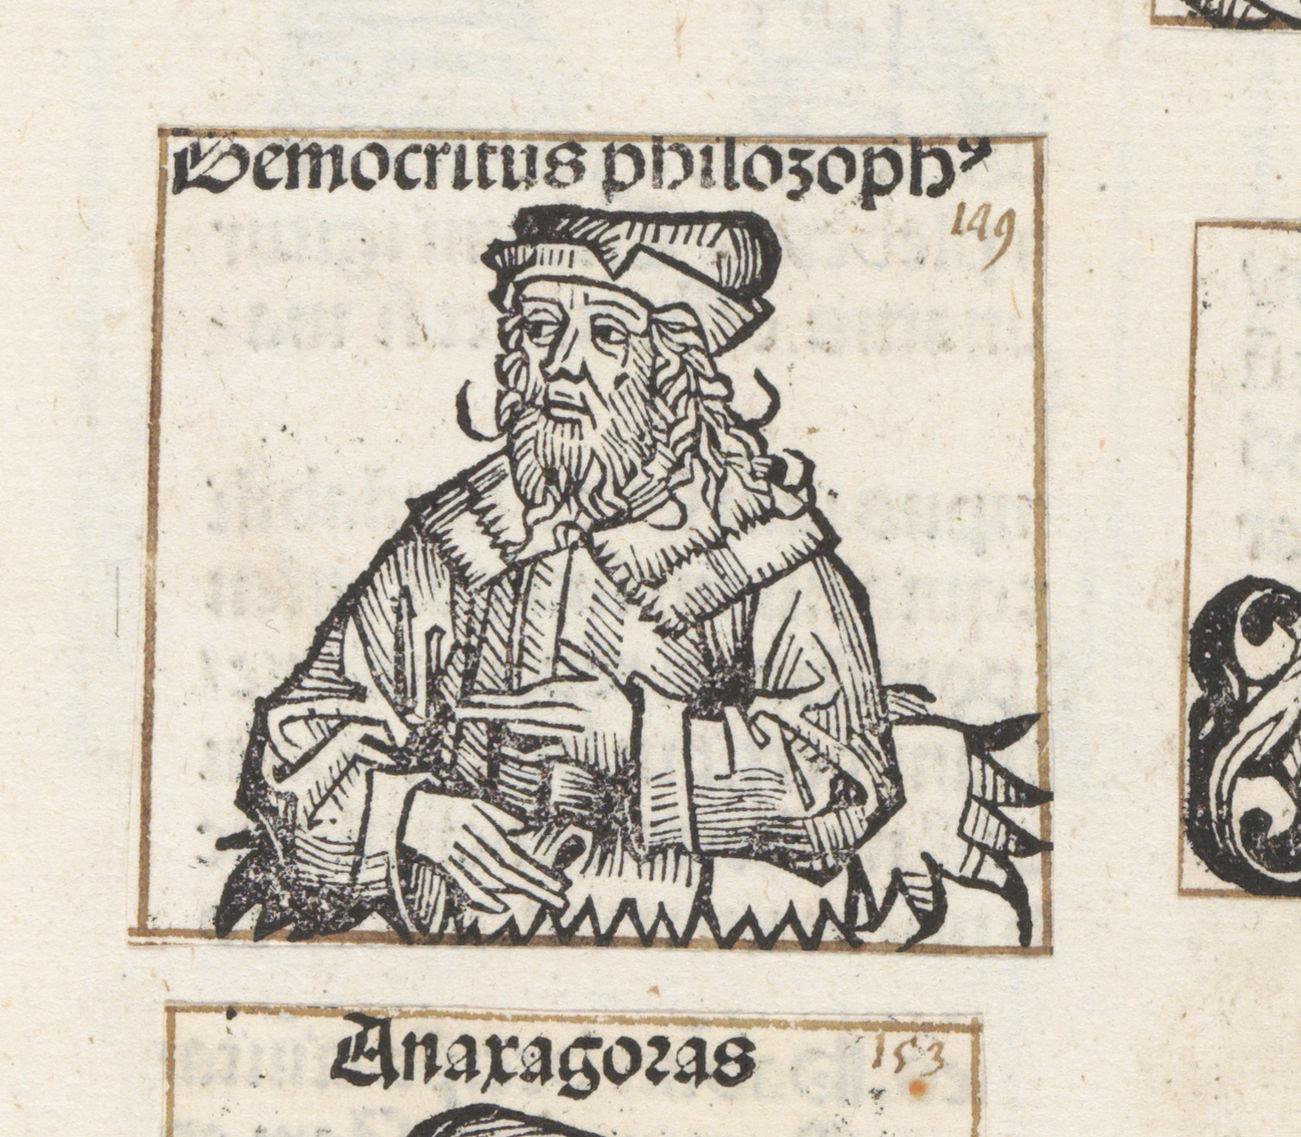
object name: album leaf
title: Democritus philosoph[us]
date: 1493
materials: paper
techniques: letterpress printing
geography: nuremberg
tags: traveler, male persons from classical history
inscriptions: inscription: ‘149’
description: De houtsnede wordt gebruikt als boekillustratie in de Liber Chronicarum (of Neurenbergkroniek) van Hartmann Schedel, verschenen in het Latijn en Duits in 1493. Zie de Latijnse uitgave, folio 70v.